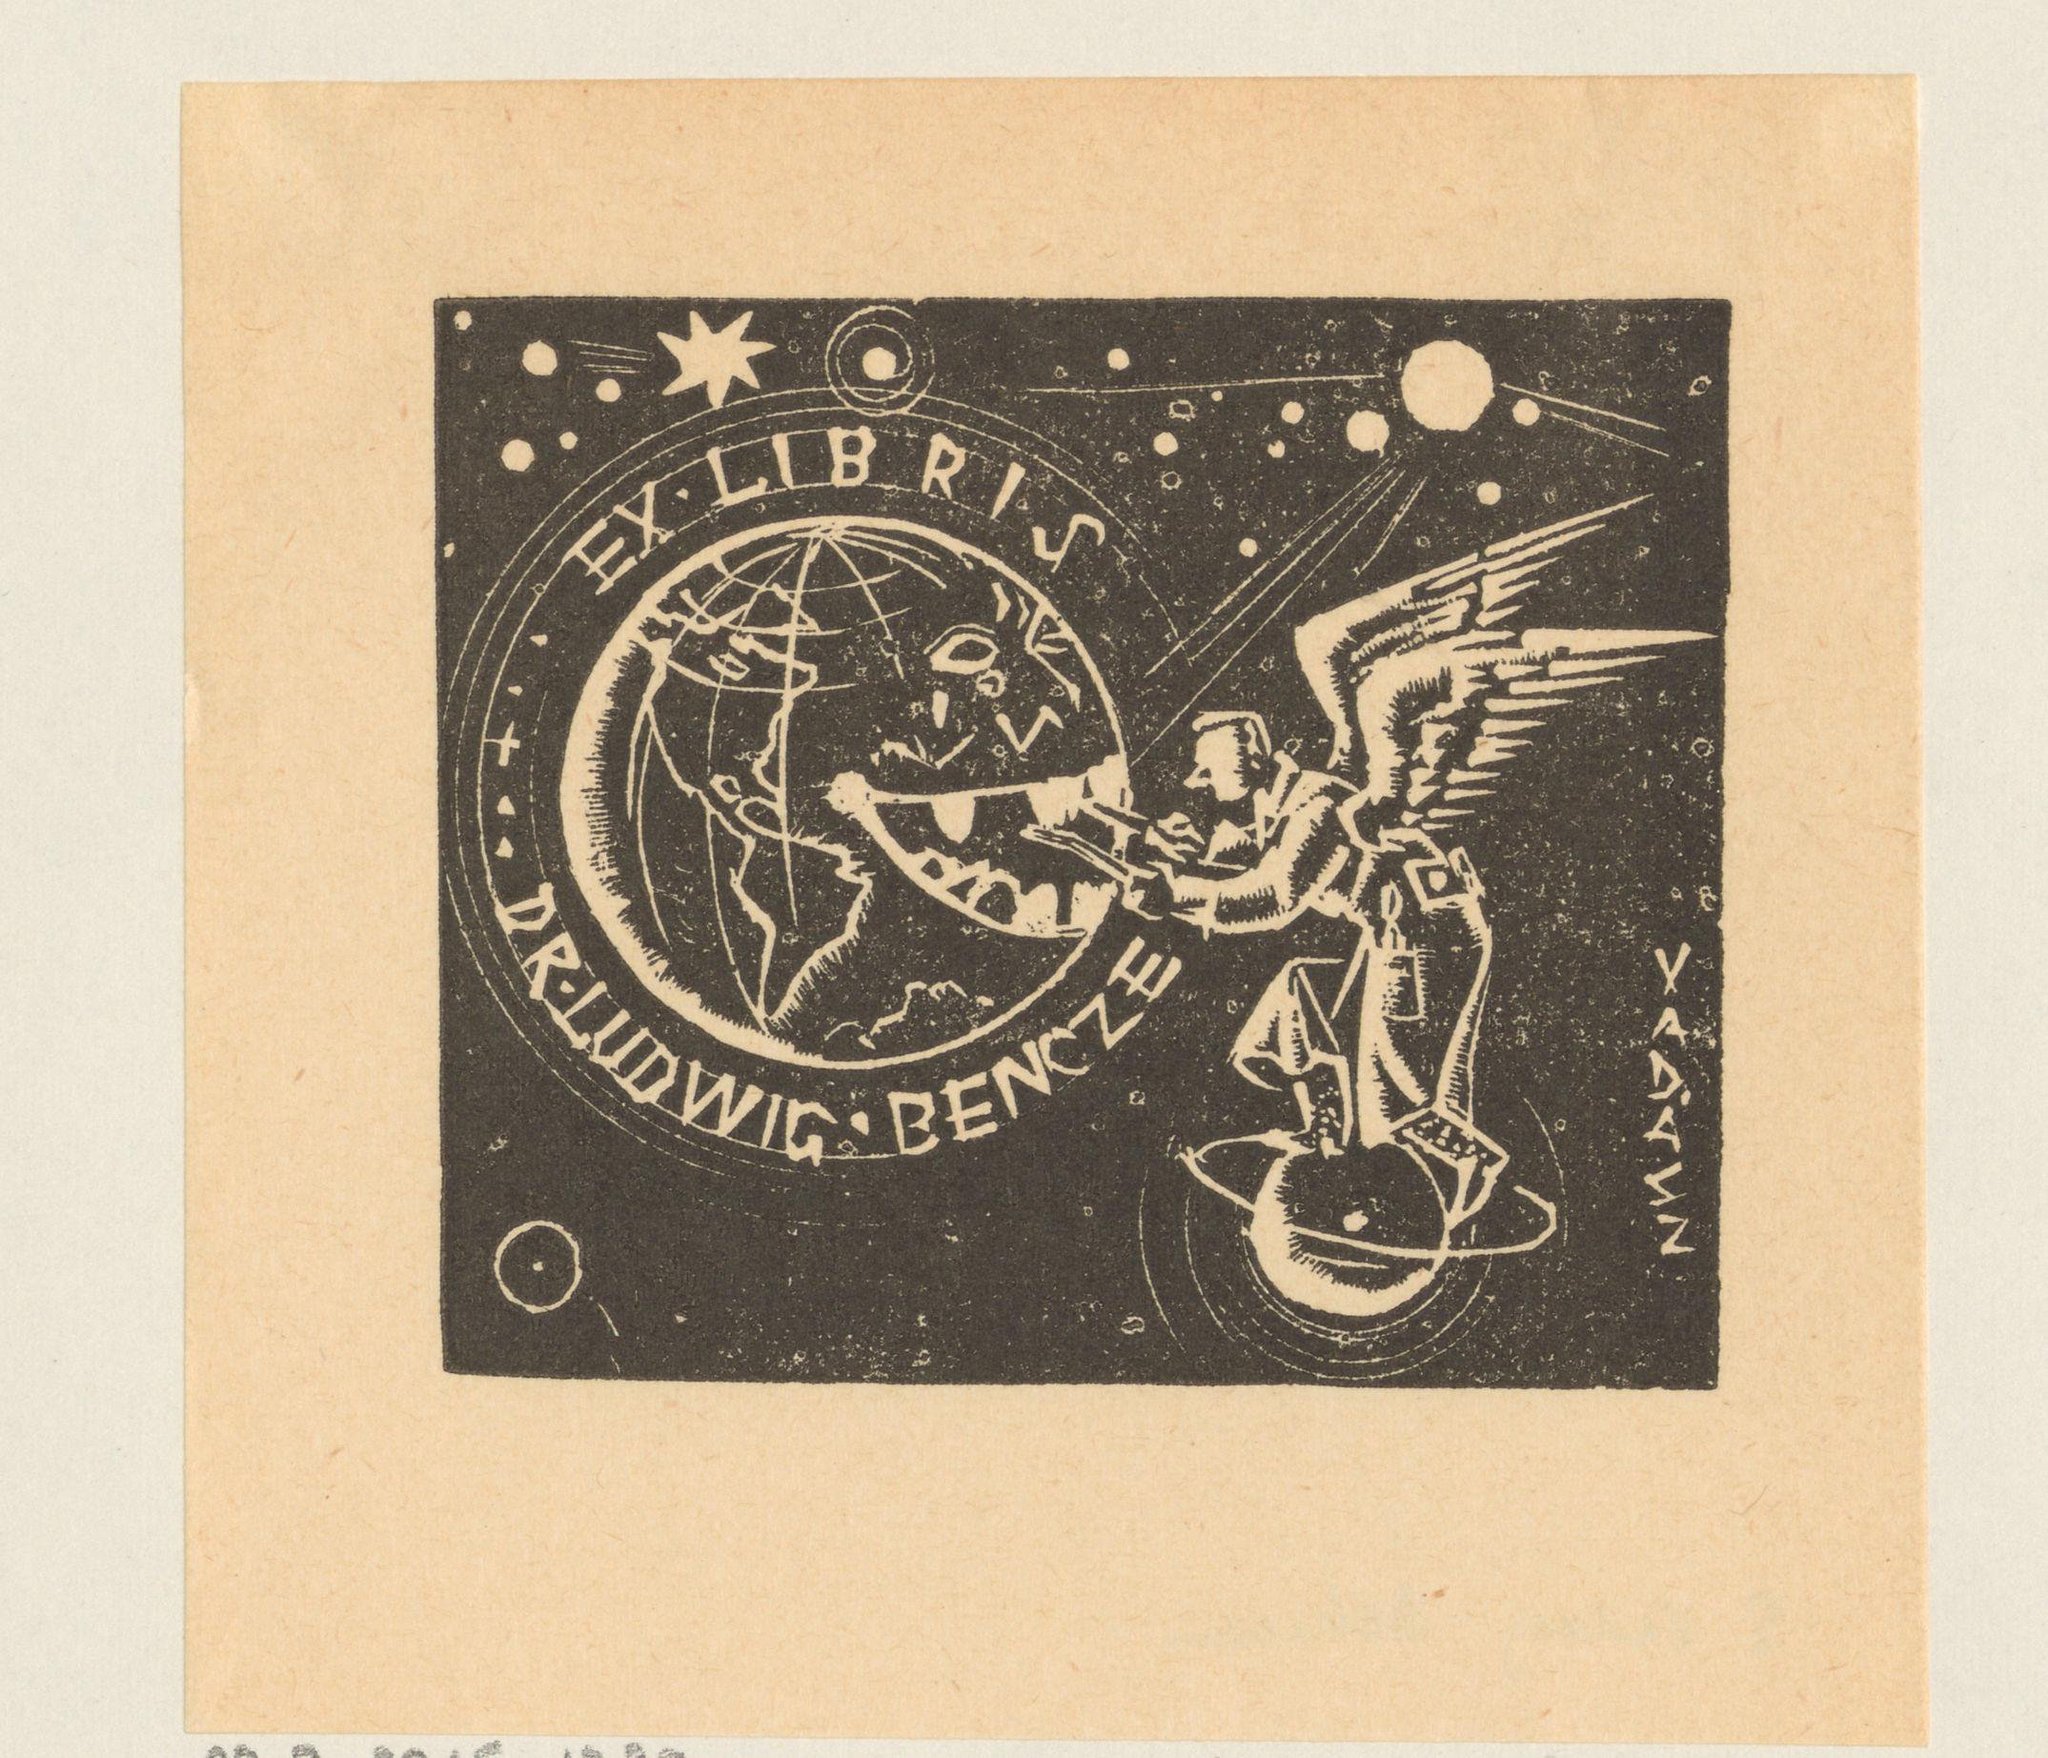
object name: bookplate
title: Ex libris van dr. Bencze Ludwig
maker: endre vadász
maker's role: painter, print maker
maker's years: 1901-1944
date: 1911-1944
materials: paper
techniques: woodcut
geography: hungary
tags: angels, planets; planetary system, solar system